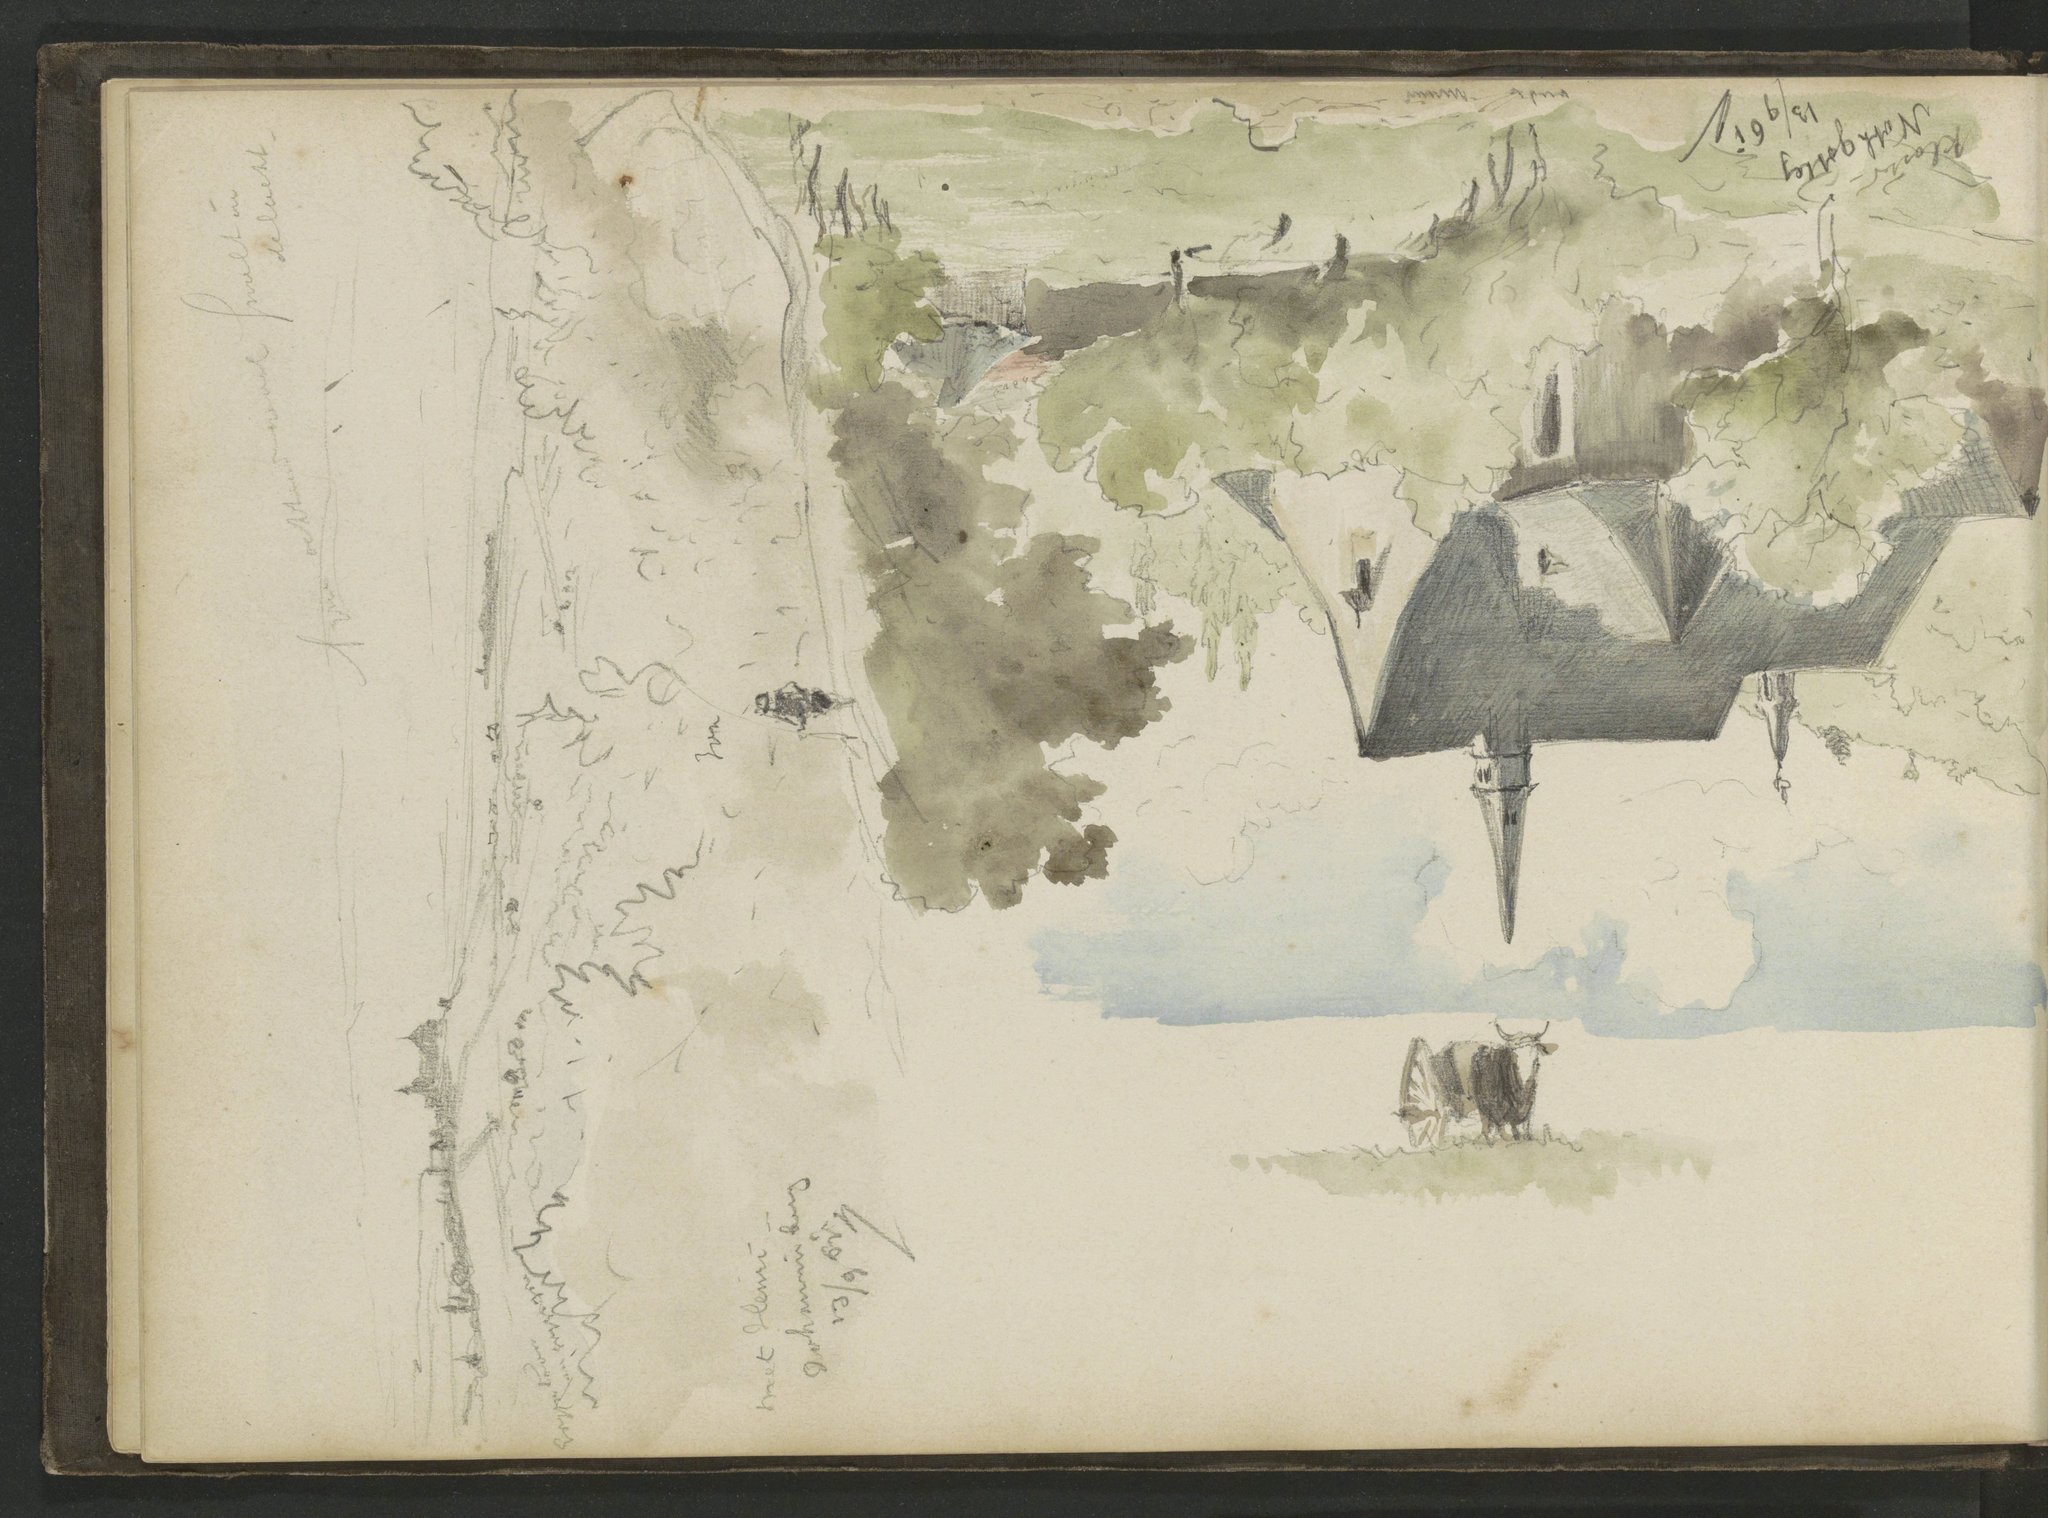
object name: sketchbook leaf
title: Klooster Nothgottes en Slot Johannisberg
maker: johannes tavenraat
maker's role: draughtsman, painter, print maker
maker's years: 1809-1881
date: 1809-1861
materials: paper, pencil, watercolor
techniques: brush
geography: rüdesheim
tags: city-view, and landscape with man-made constructions, castle, cloisters ~ monastery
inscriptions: date and inscription: ‘kloster/ Nothgottes/ 13/9 61/ met Henri/ Johannisberg/ 13/9 61’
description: Blad 10 verso uit een schetsboek met 57 bladen.